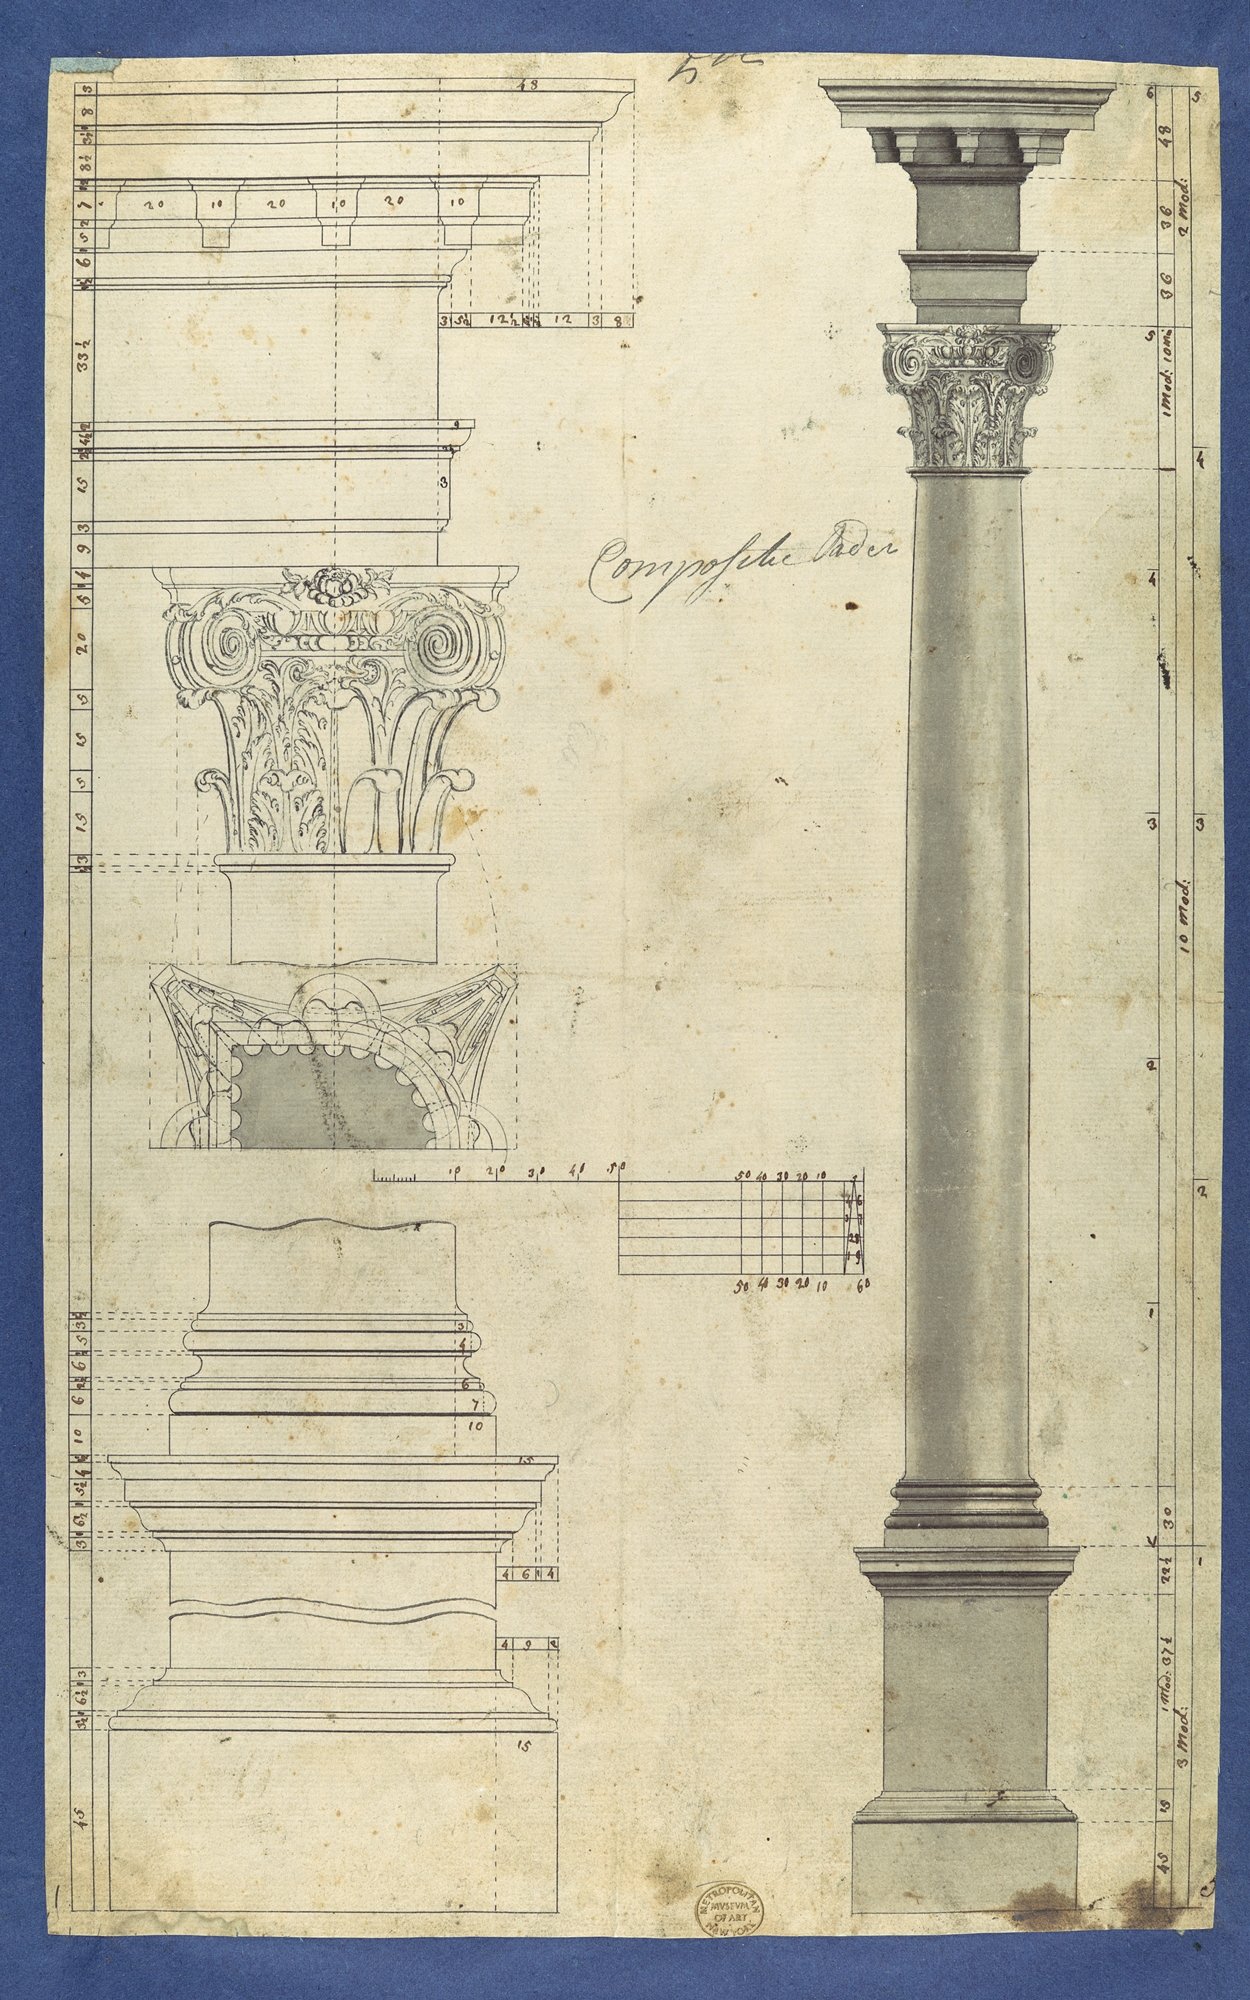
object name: drawing ornament architecture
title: The General Proportions of the Composite Order, in Chippendale Drawings, Vol. I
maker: thomas chippendale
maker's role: artist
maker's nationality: british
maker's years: 1718-1779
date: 1753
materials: ink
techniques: wash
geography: london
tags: capitals,columns